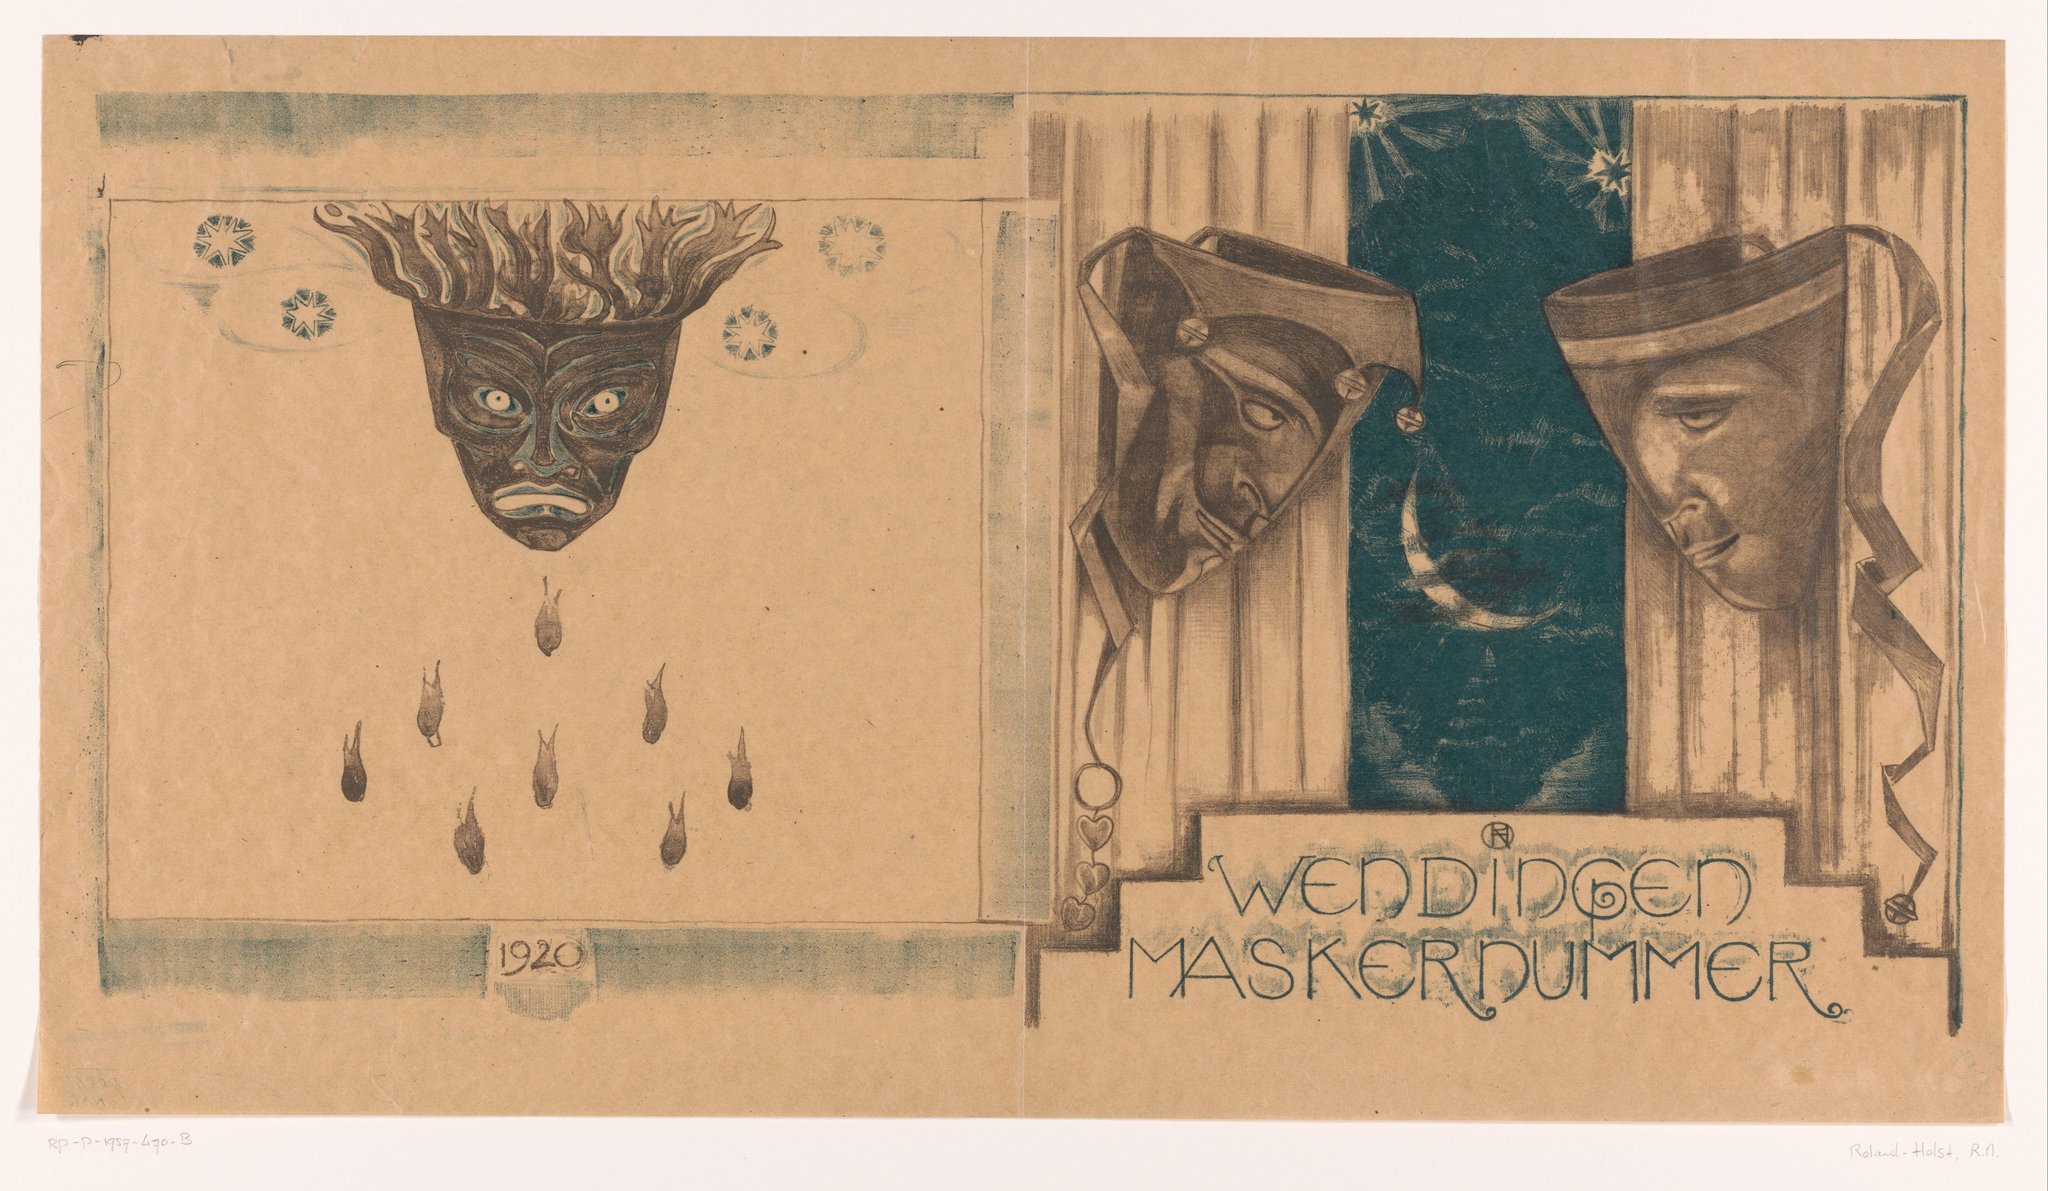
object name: wrapper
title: Omslagontwerp voor: Wendingen, Maskernummer, 1920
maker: richard nicolaüs roland holst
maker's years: 1868-1938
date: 1920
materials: paper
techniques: lithograph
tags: mask, court jester, court fool, night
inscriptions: collector's mark: Lugt 2228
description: Links een masker met geopende mond. Bij het masker vier sterren en acht vlammen. Rechts twee maskers van een nar. Tussen de narrenmaskers door zicht op een nachtelijke hemel met twee sterren en de krimpende maan.